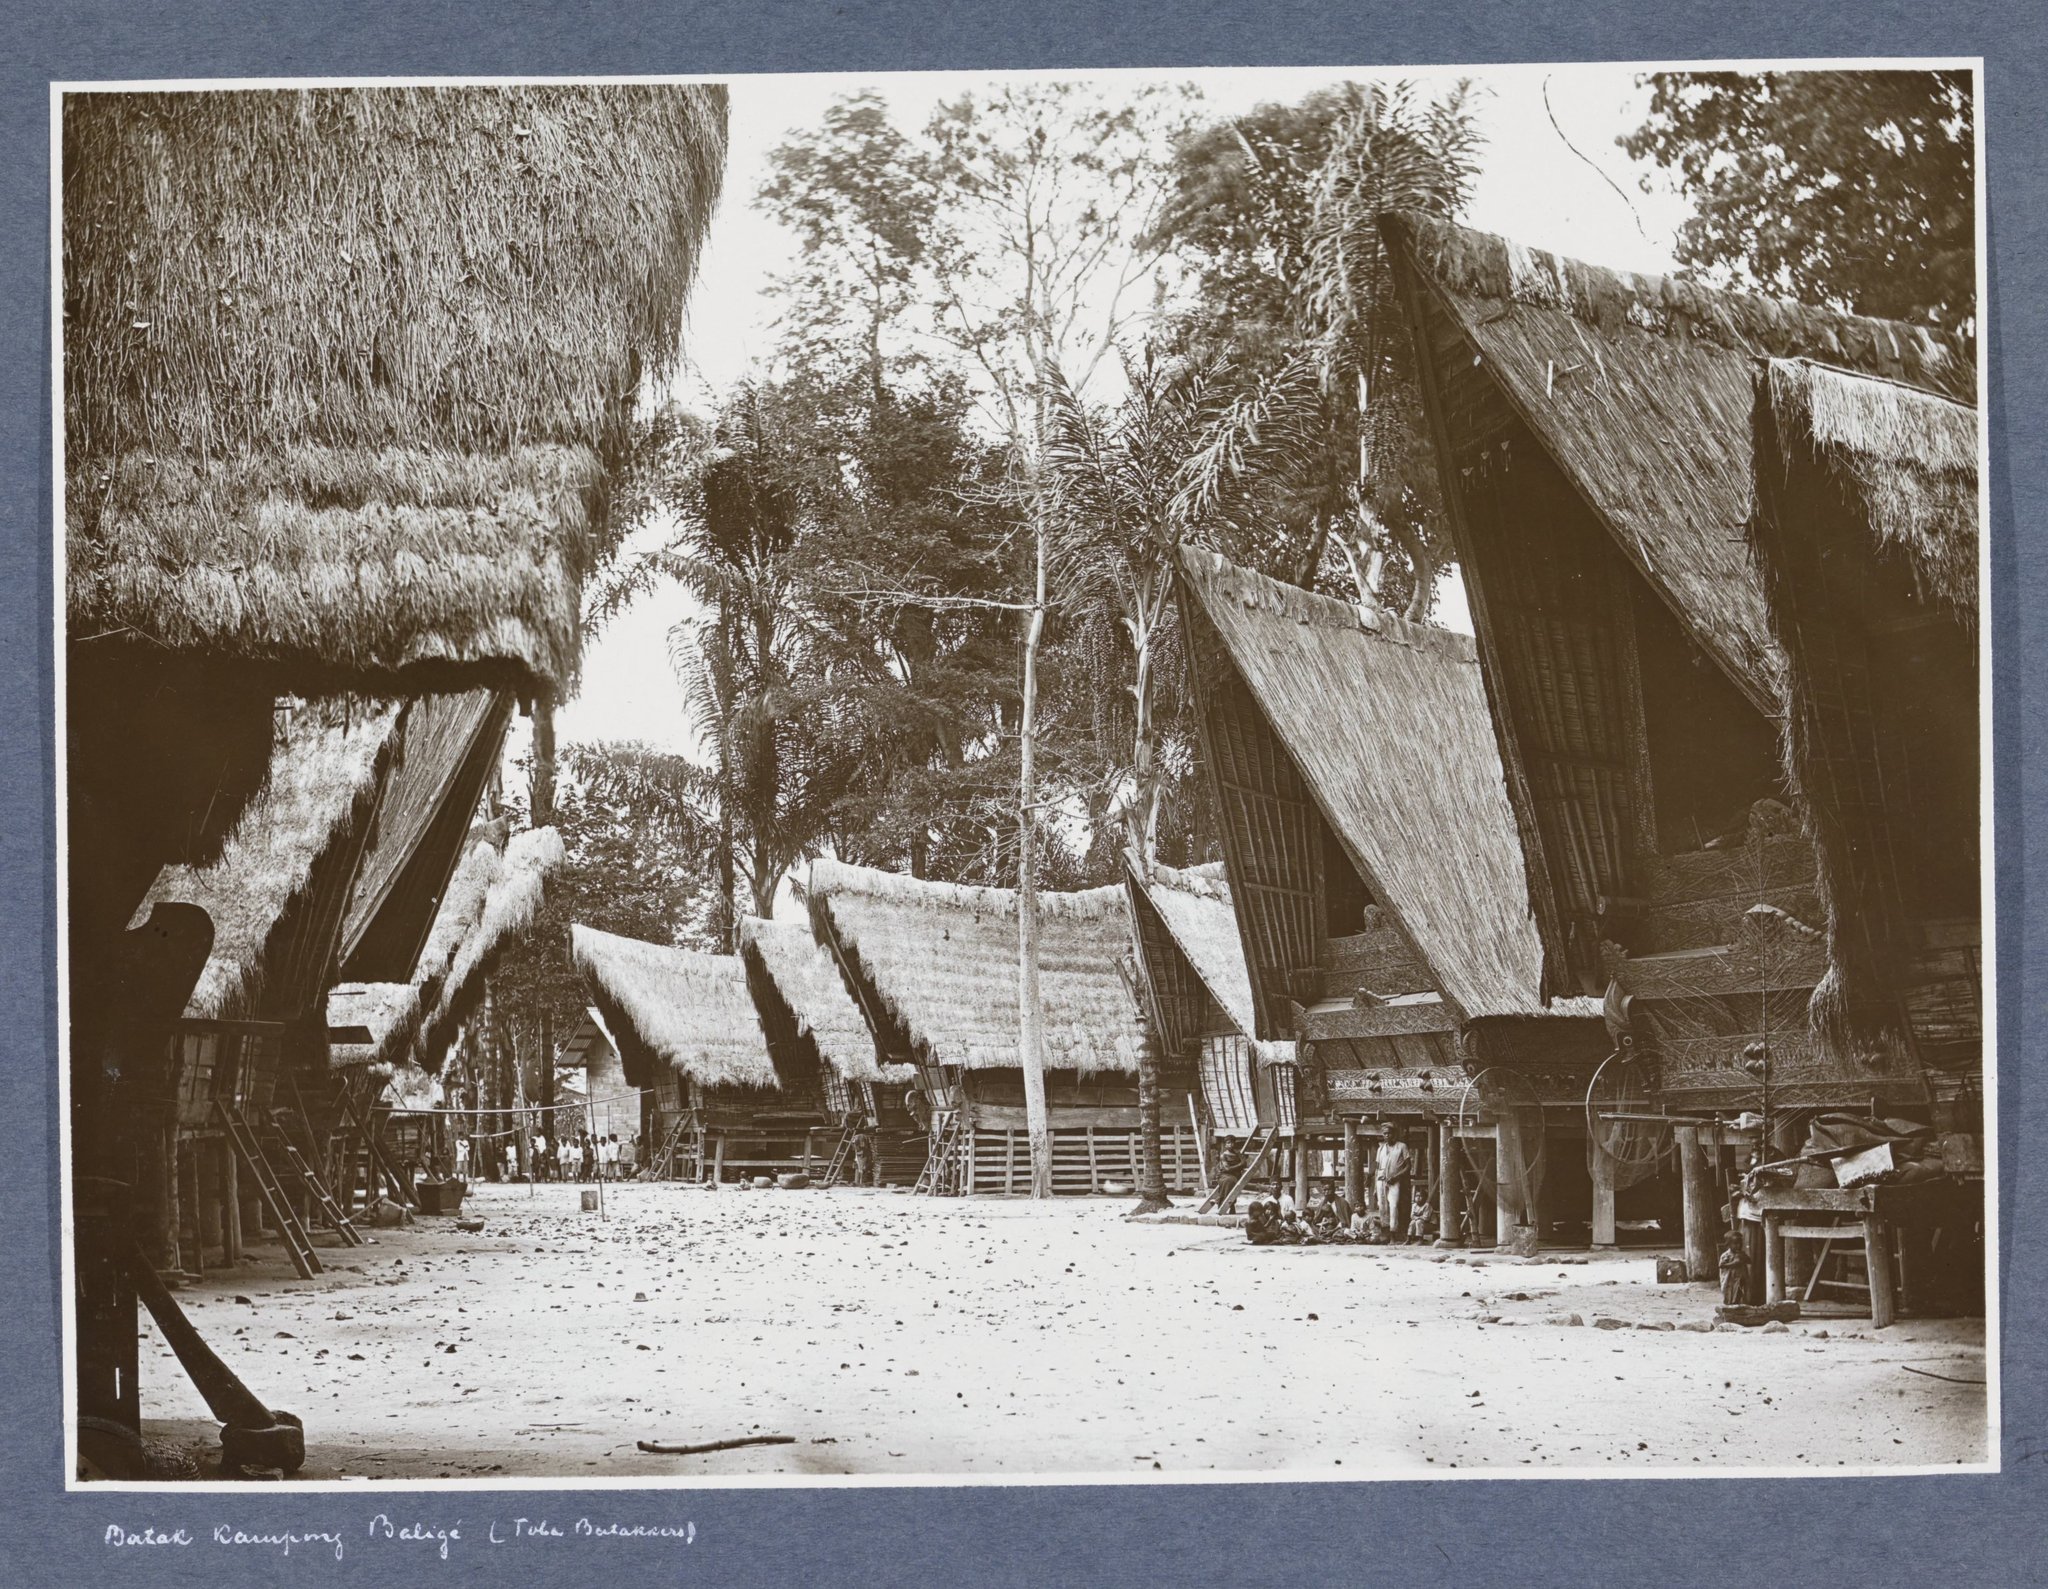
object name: album leaf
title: Kampong Balige van Toba Batakkers op Sumatra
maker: christiaan benjamin nieuwenhuis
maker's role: publisher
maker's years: 1863-1922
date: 1900-1920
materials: paper, photographic support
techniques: gelatin silver print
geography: sumatra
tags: village, exterior ~ representation of a building, sumatra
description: Onderdeel van reisalbum met foto's van bedrijvigheid en bezienswaardigheden op Sumatra en Java en van de reis naar en van Nederlands-Indië.